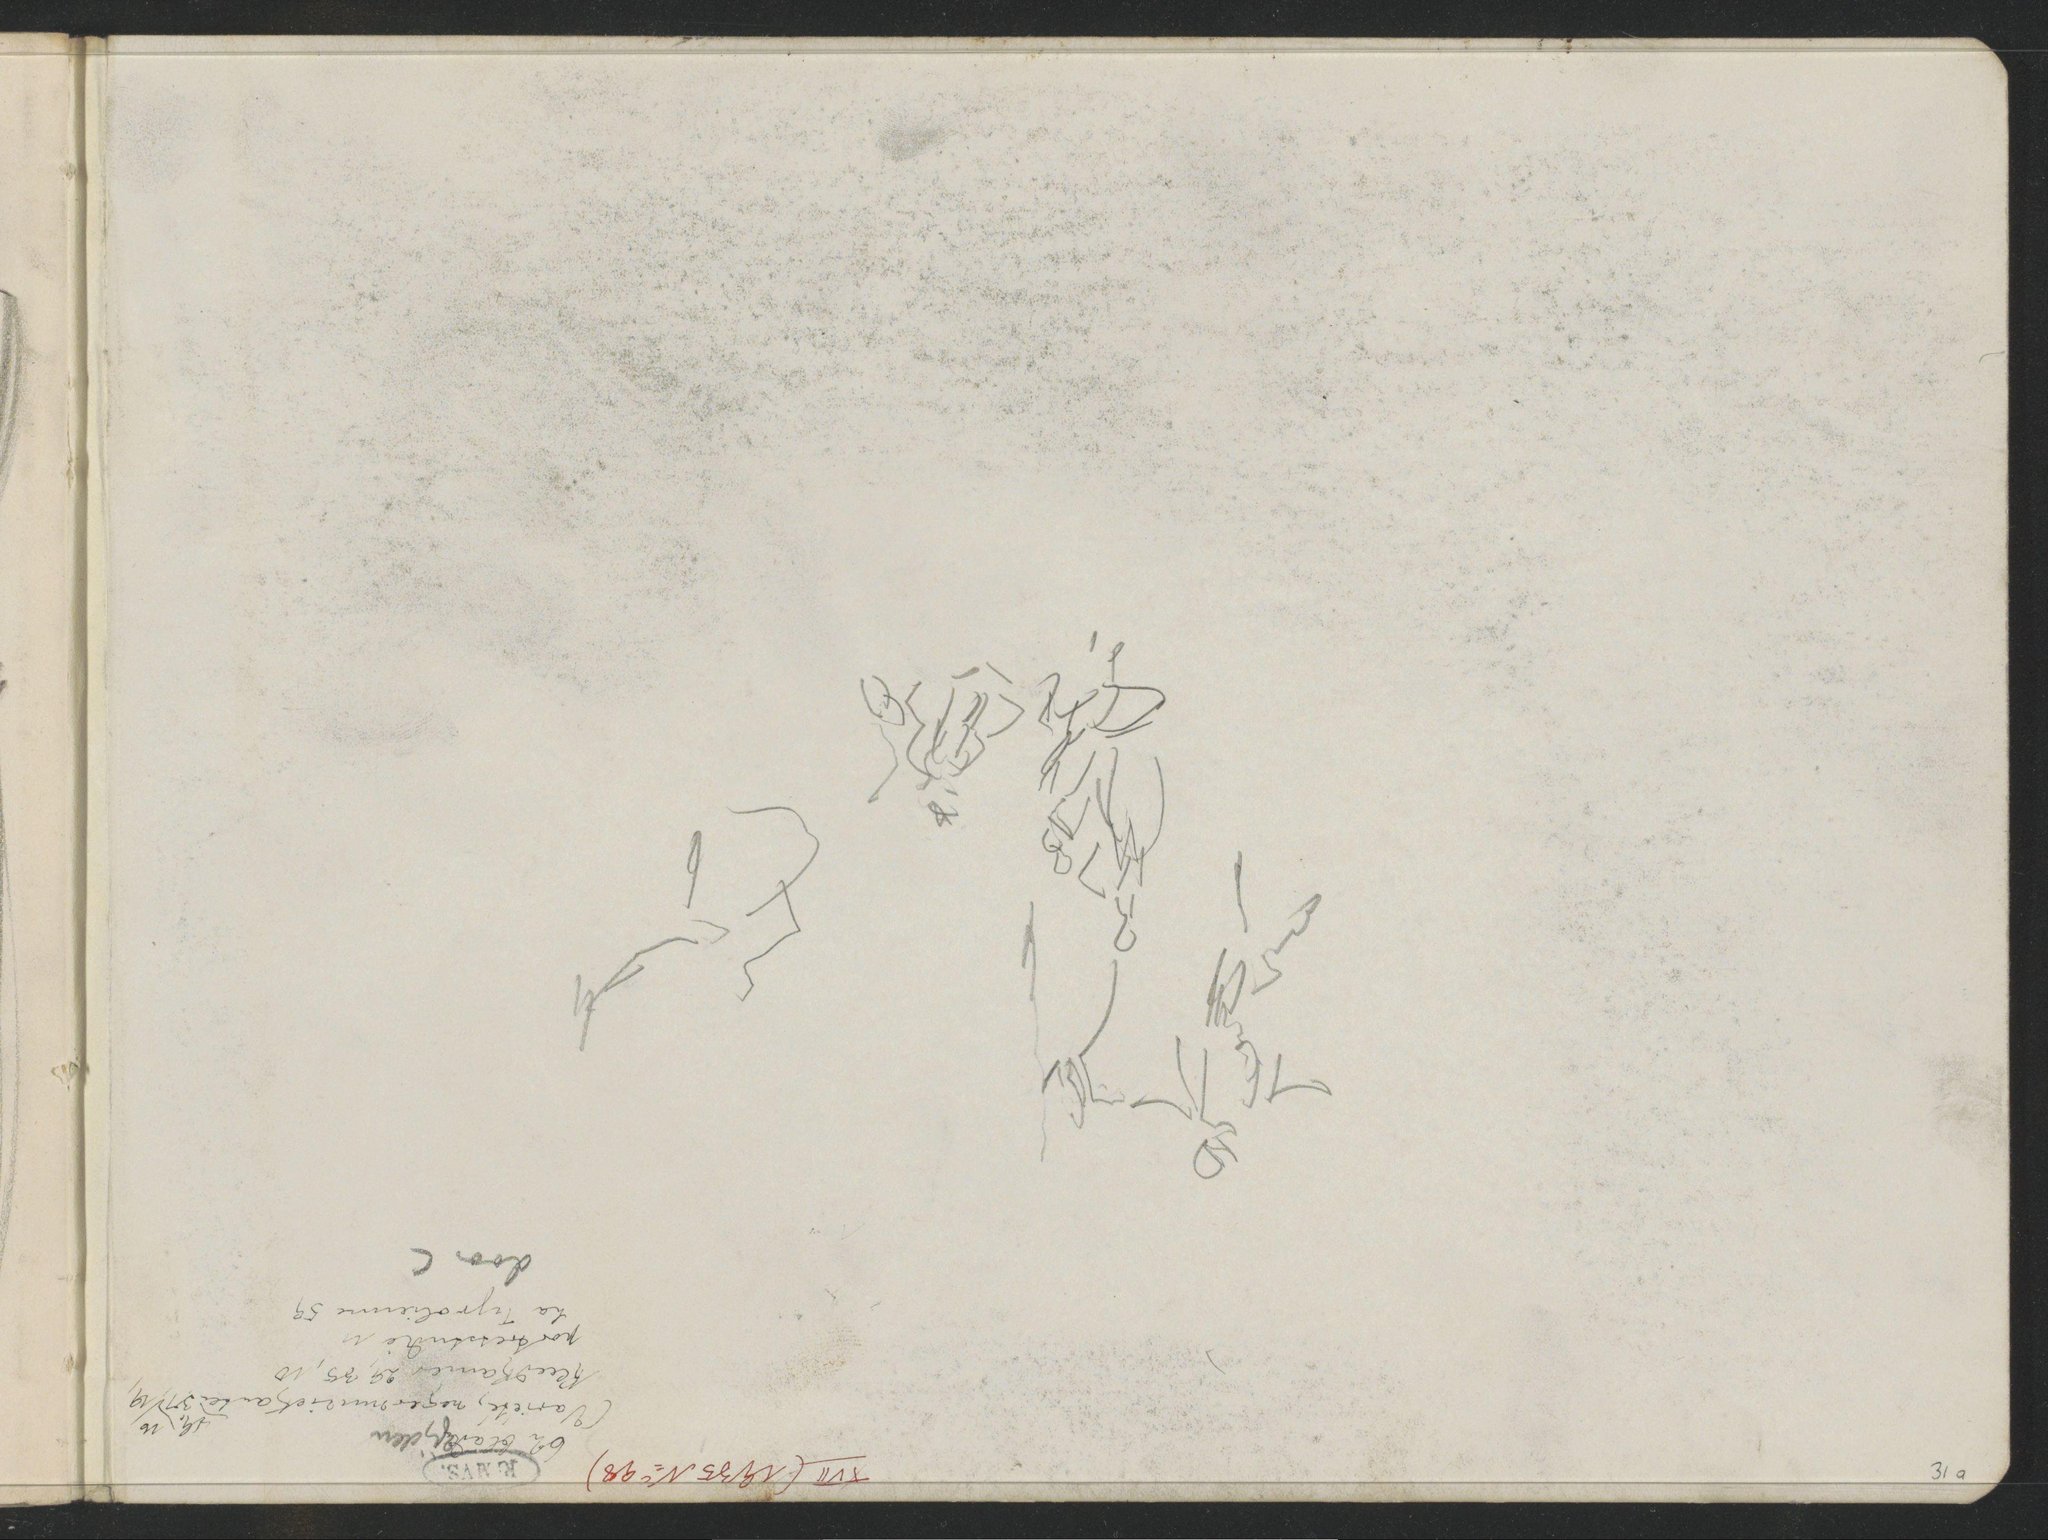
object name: sketchbook leaf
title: Figuurstudies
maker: isaac israels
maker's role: draughtsman, painter, print maker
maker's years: 1865-1934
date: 1915-1934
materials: paper, pencil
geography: the hague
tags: postures of the human figure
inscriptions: collector's mark: Lugt 2228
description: Schutblad B, achterste schutblad, uit schetsboek XVII met 31 bladen.